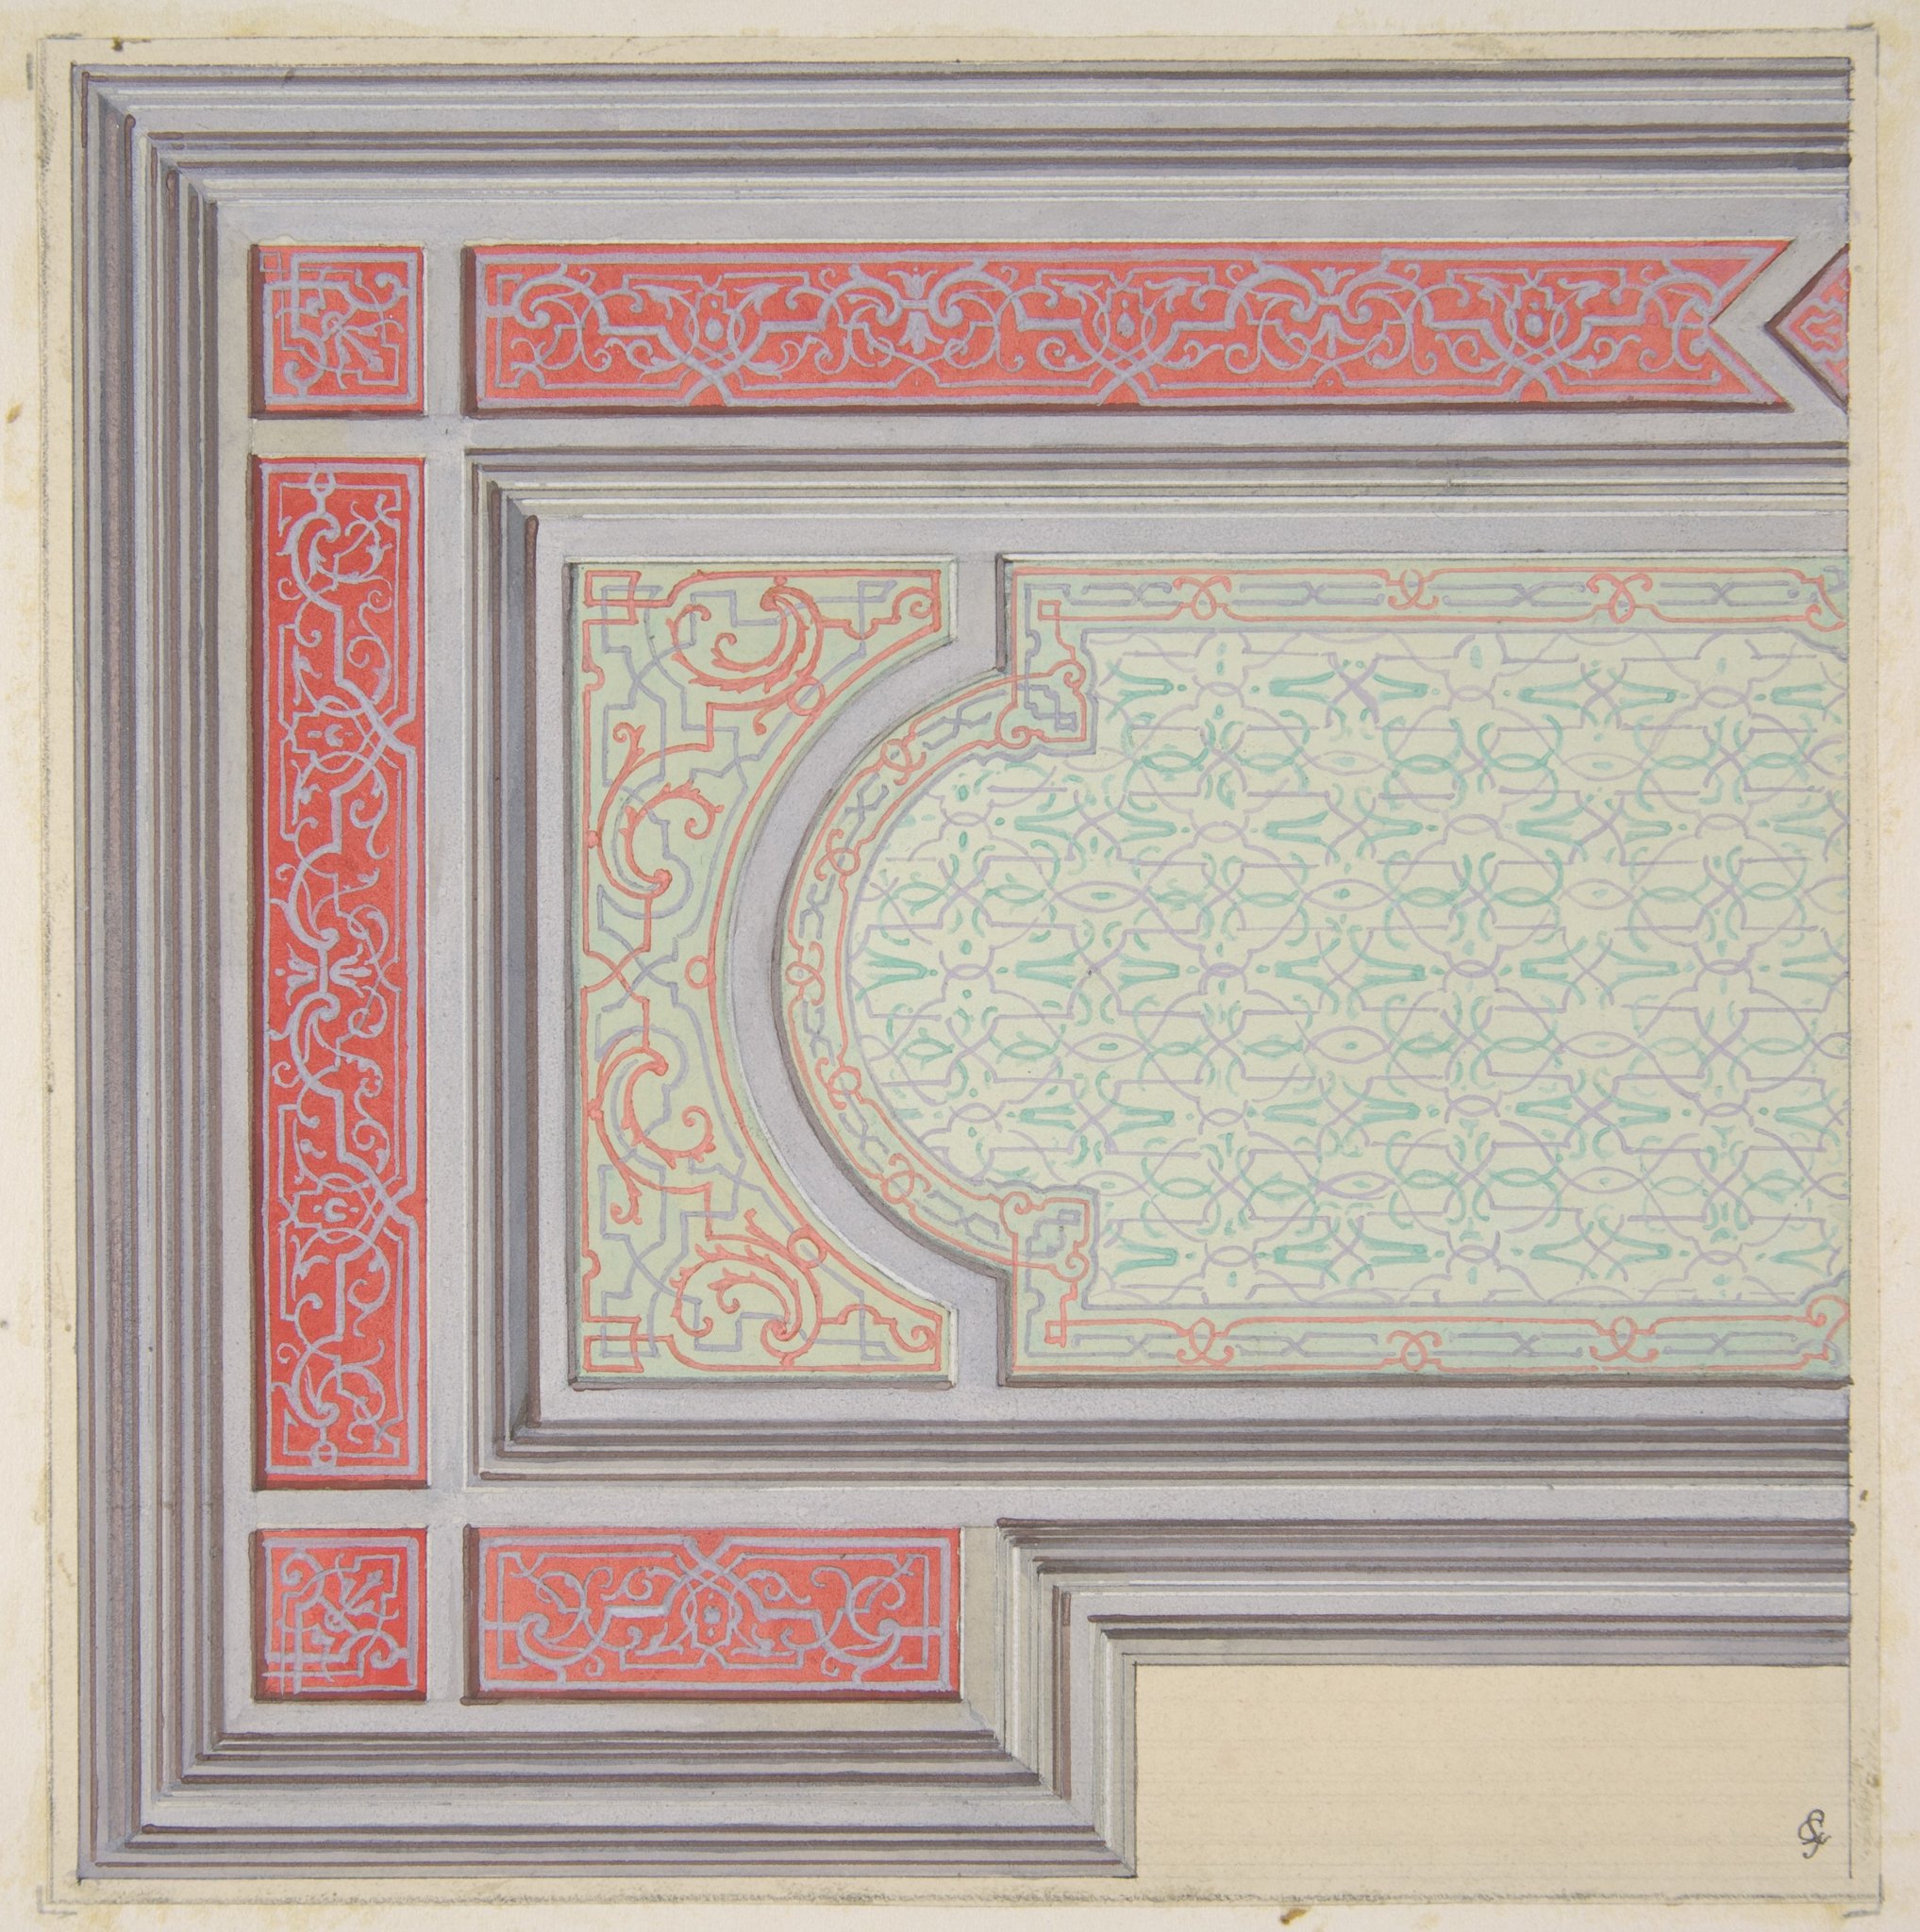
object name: drawing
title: Design for the decoration of a ceiling in strapwork and rinceaux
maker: jules-edmond-charles lachaise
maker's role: artist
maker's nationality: french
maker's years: 1897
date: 1830-1897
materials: ink, watercolor, paper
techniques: pen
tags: ceilings